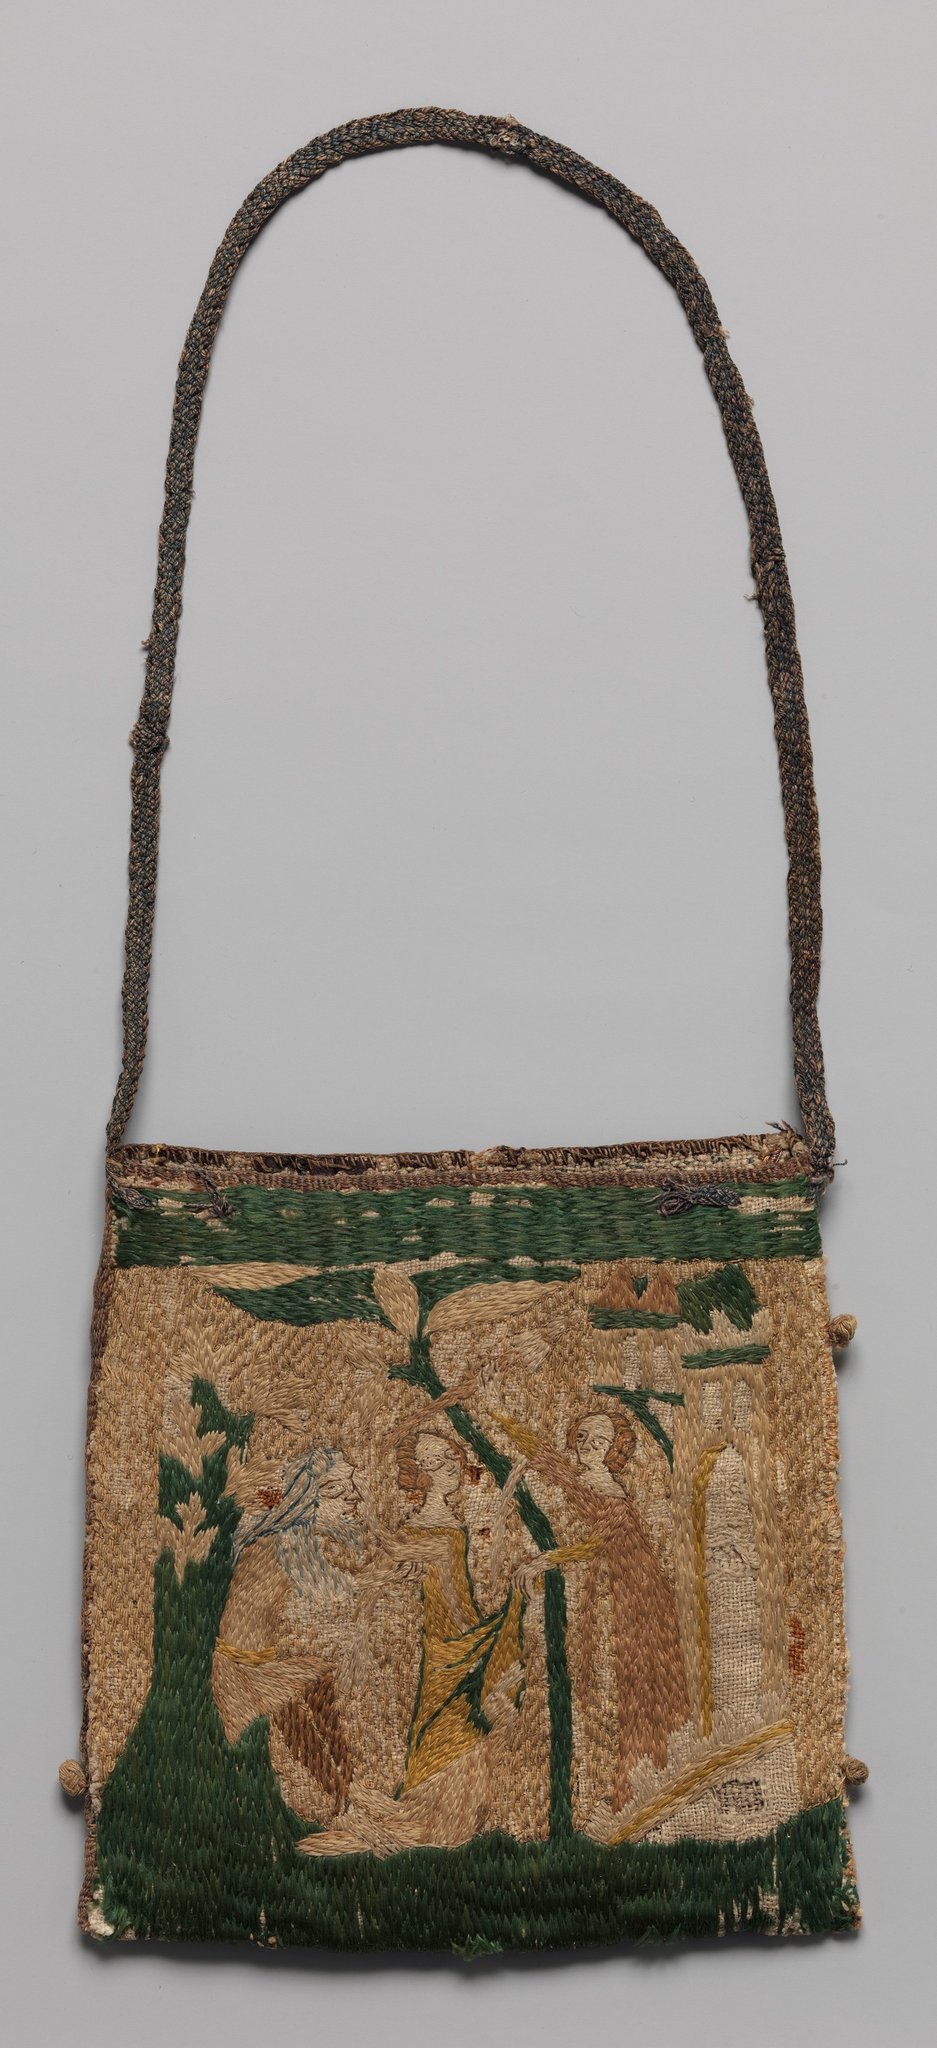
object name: purse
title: Purse with scenes from the story of Patient Griselda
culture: french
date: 1301-1400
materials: canvas, metal thread, silk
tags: men,women,horses